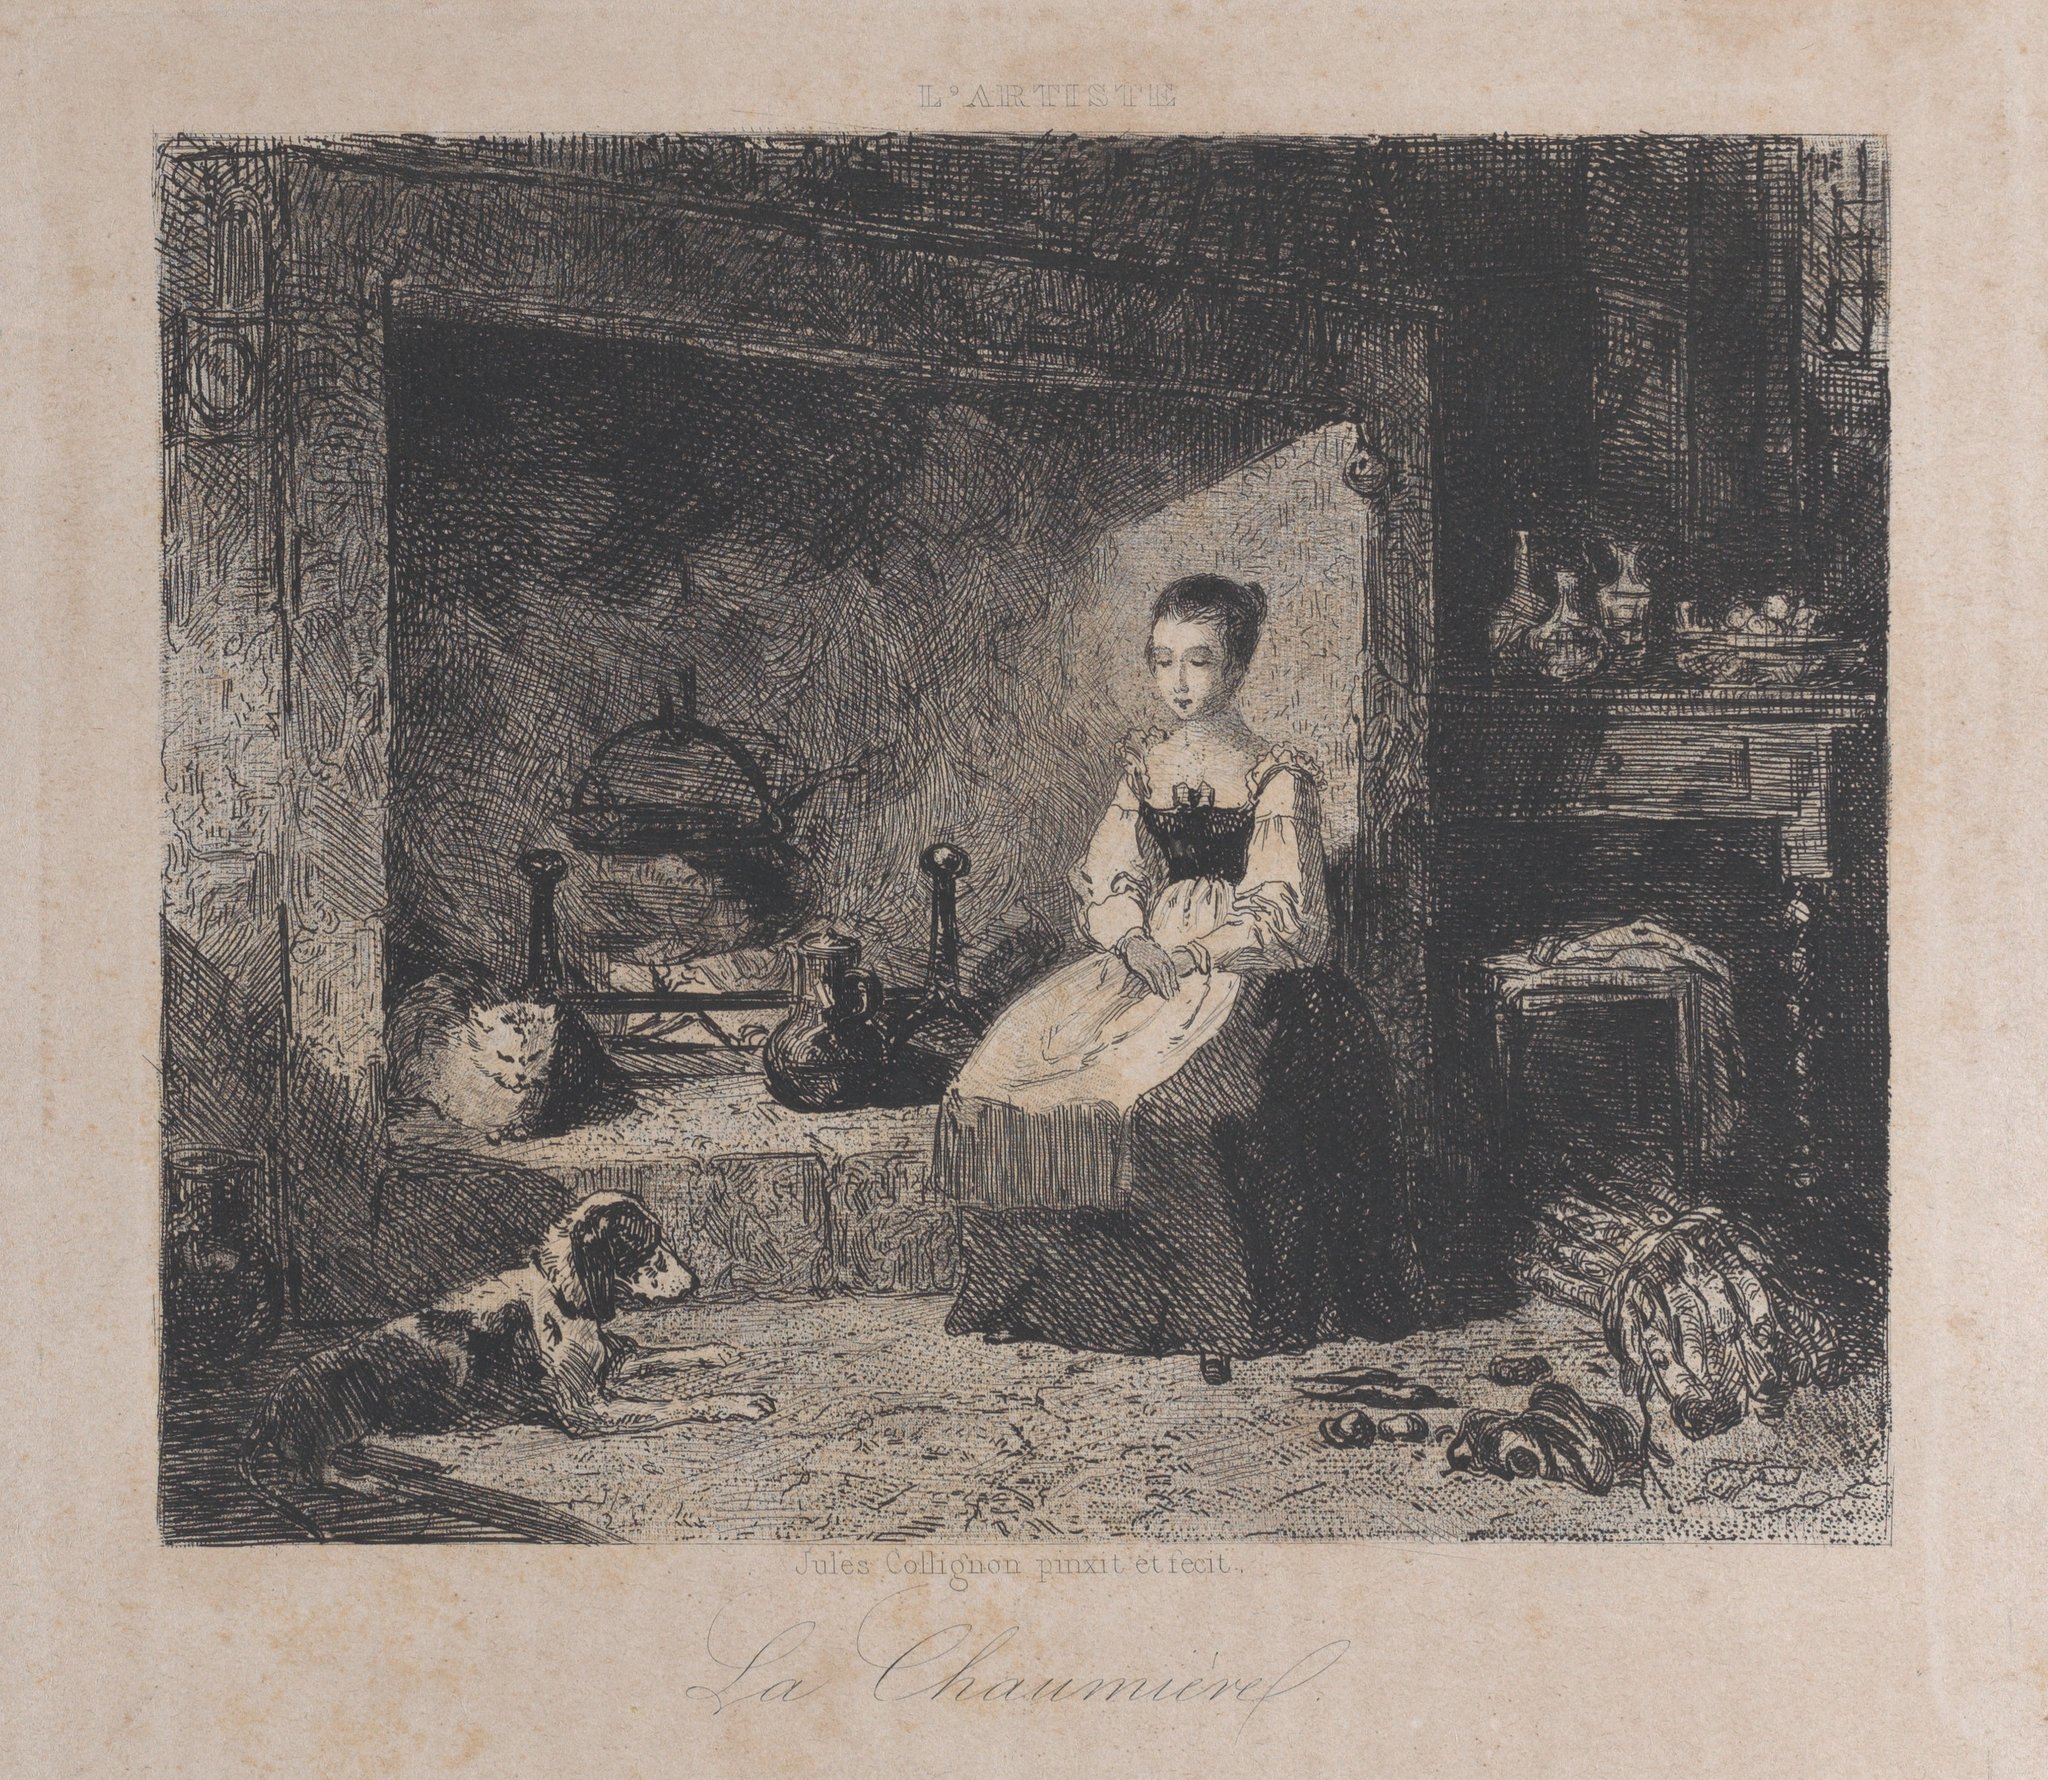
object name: print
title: The Cottage (La Chaumière)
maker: françois jules collignon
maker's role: artist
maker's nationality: french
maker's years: 1750-1850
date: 1800-1850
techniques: etching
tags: fireplaces,interiors,women,cats,dogs